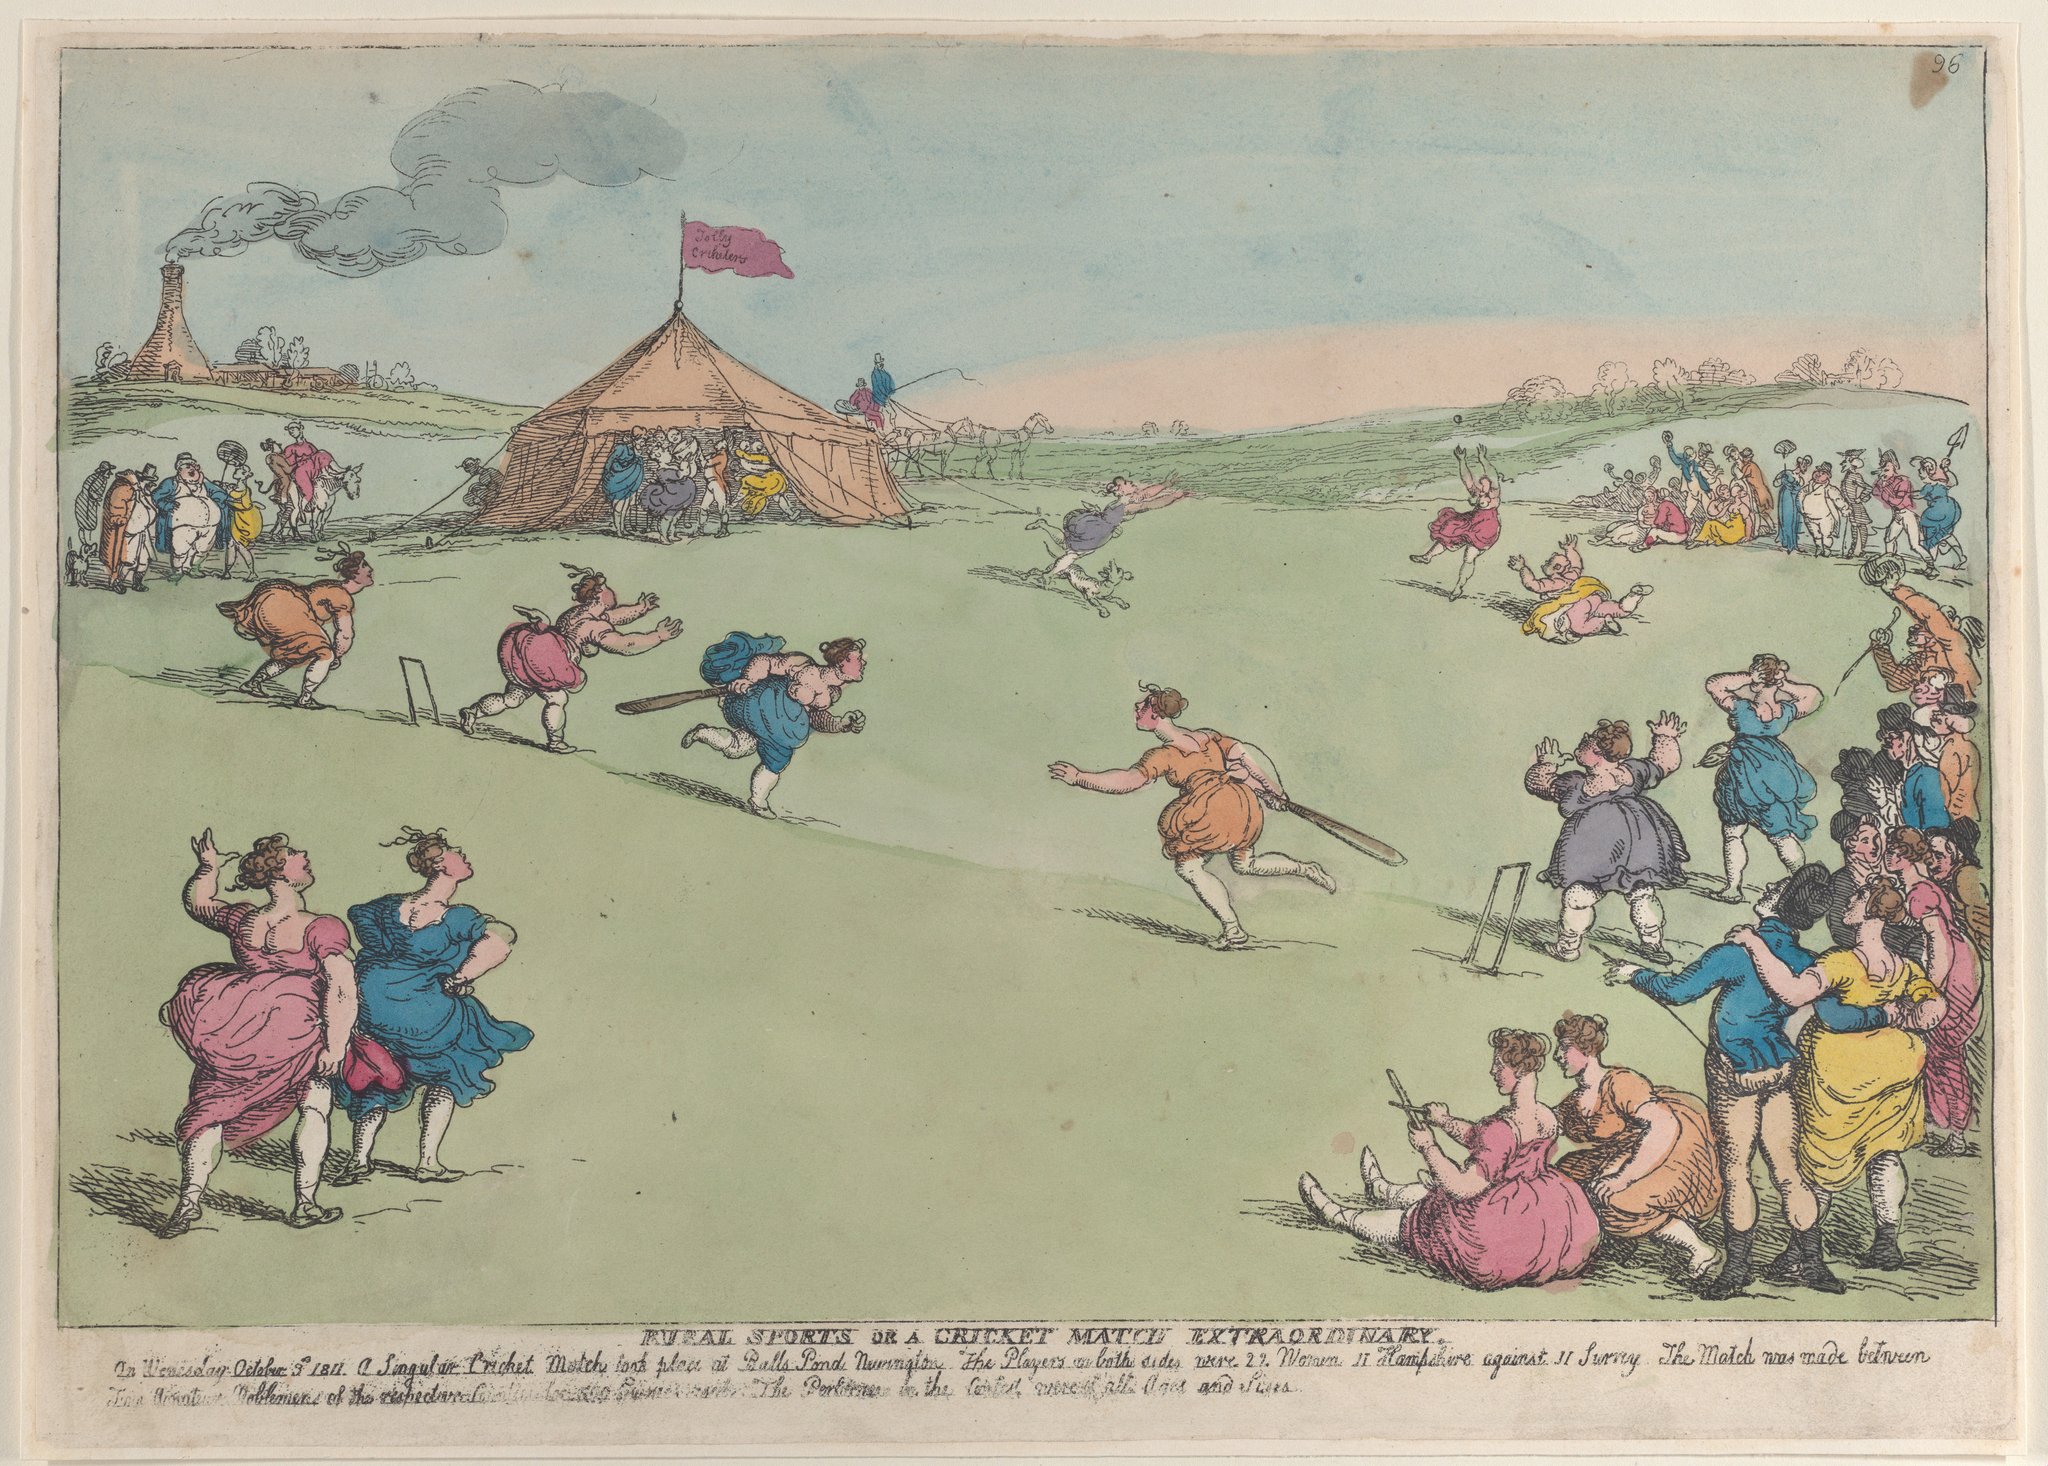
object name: print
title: Rural Sports or a Cricket Match Extraordinary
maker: thomas rowlandson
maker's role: artist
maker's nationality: british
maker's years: 1757-1827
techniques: etching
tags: satire,women,sports,games